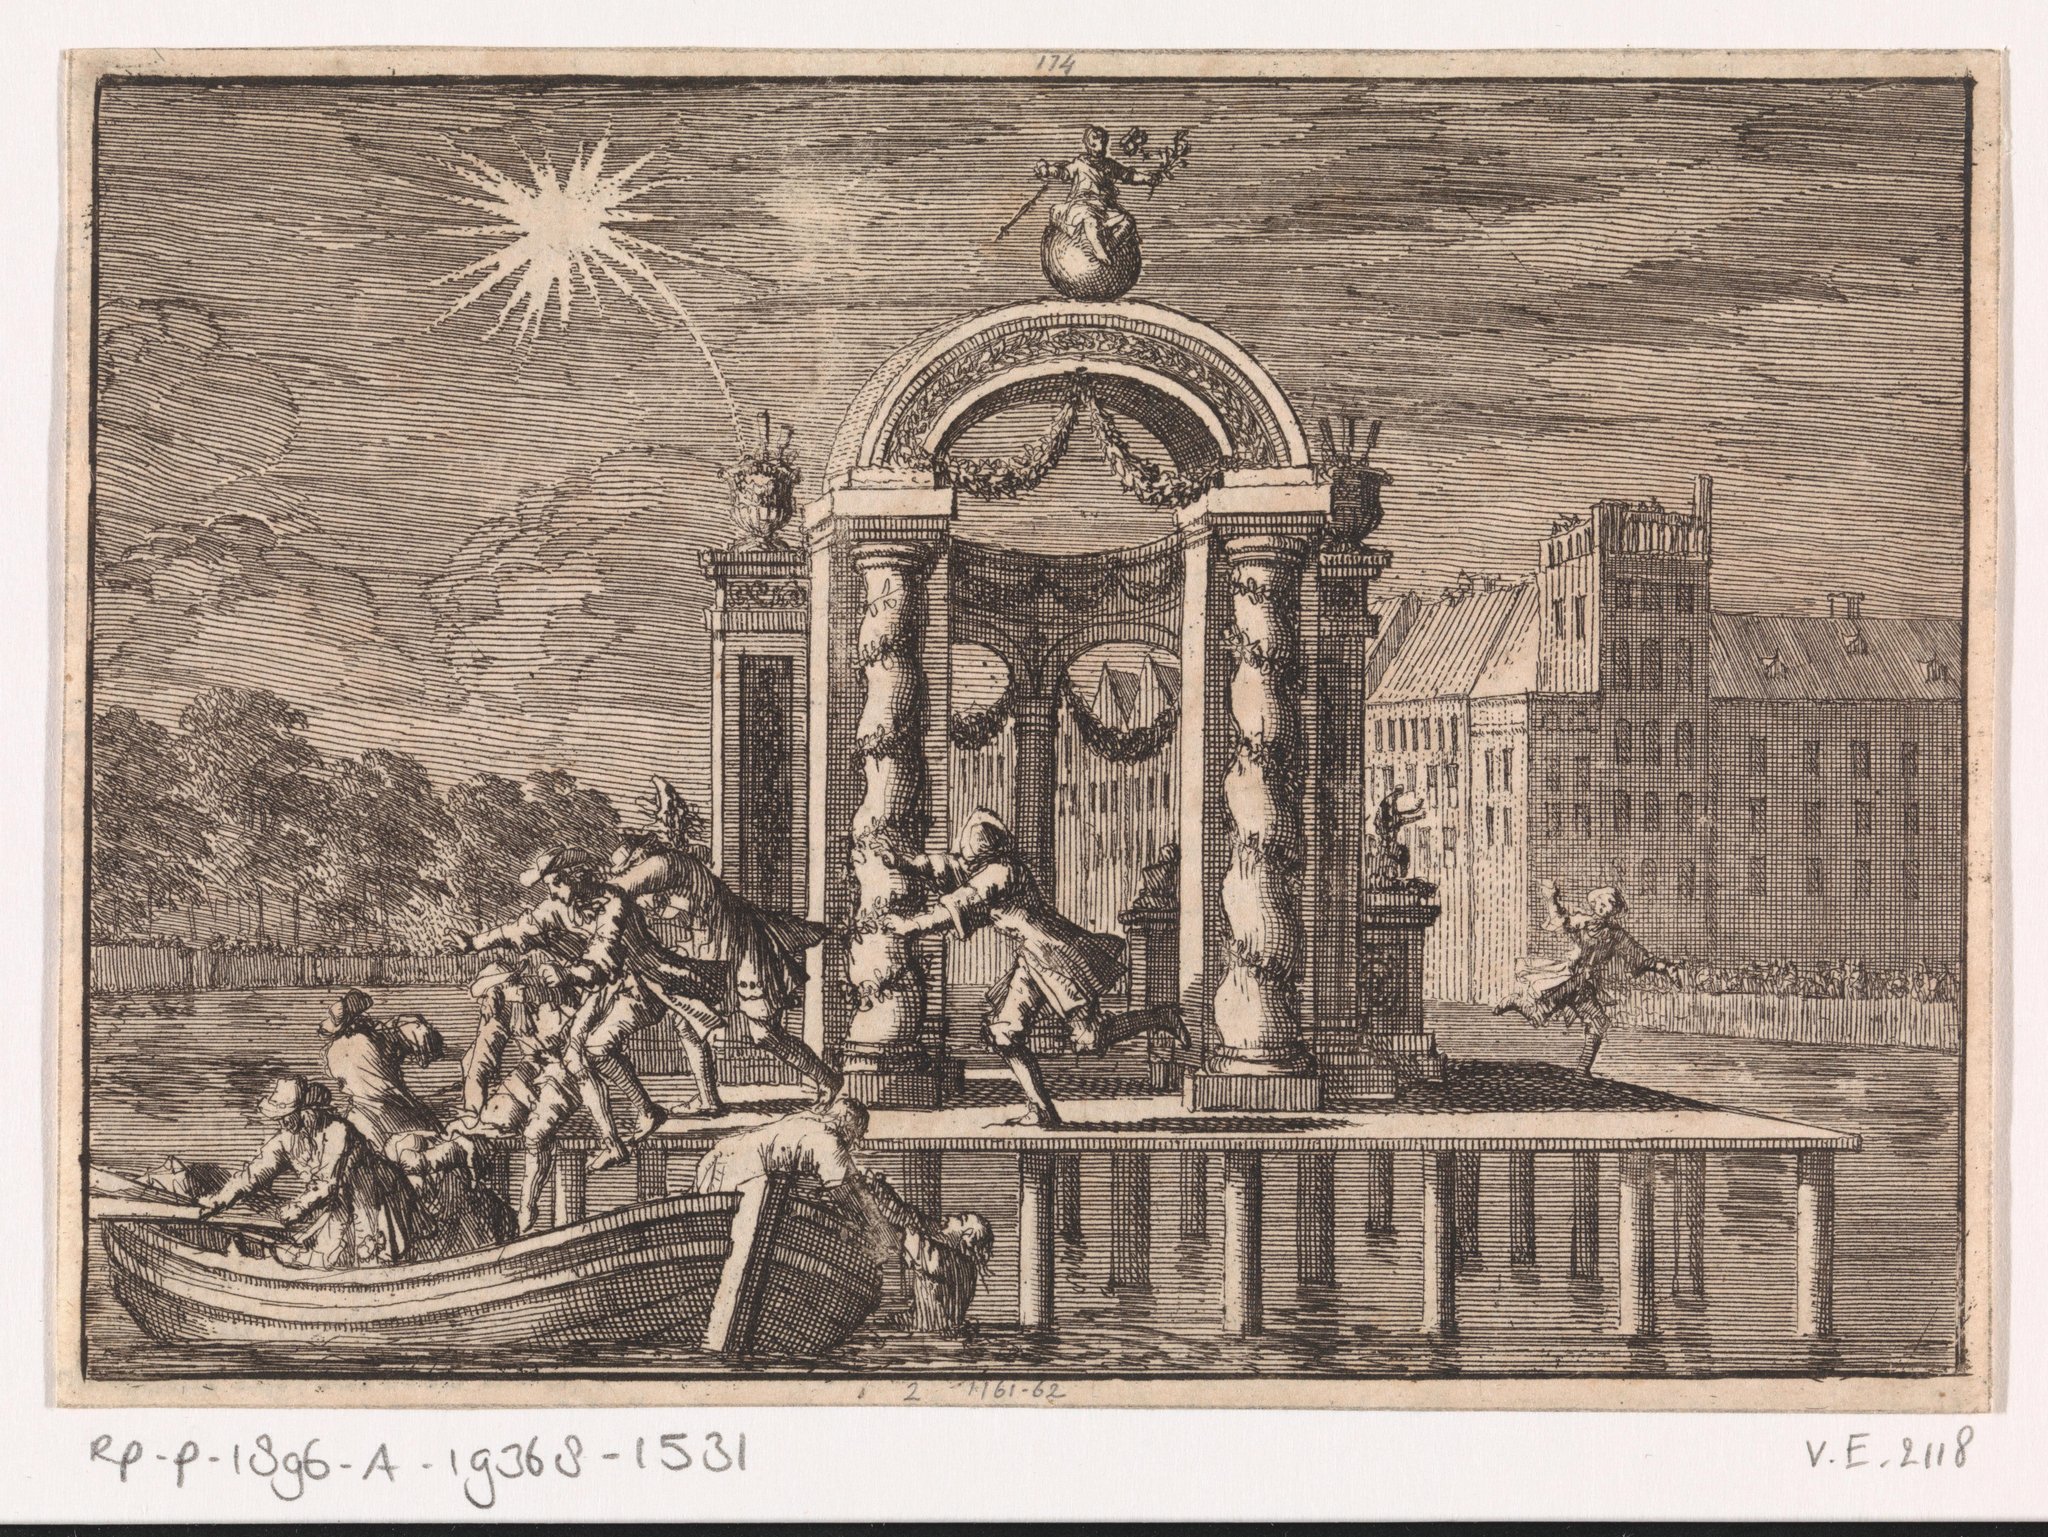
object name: print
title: Vluchtende pyrotechnici bij een grote versiering op de Vijverberg te Den Haag ter ere van de geboorte van de zoon van koning Jacobus II, 1688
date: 1698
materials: paper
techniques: etching, letterpress printing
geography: amsterdam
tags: london, rome, bonfire, fire-works - aa - festivities on the water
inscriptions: collector's mark: Lugt 2228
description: Illustratie uit: Gottfried, Johann Ludwig. Historische kronyck; vervattende een (...) beschrijvingh der aldergedenckwaerdigste geschiedenissen des weerelds, van den aenvangh der scheppingh tot (...) 1576 (2 delen). Leiden: Pieter van der Aa, 1698, dl. II, p. 1161.